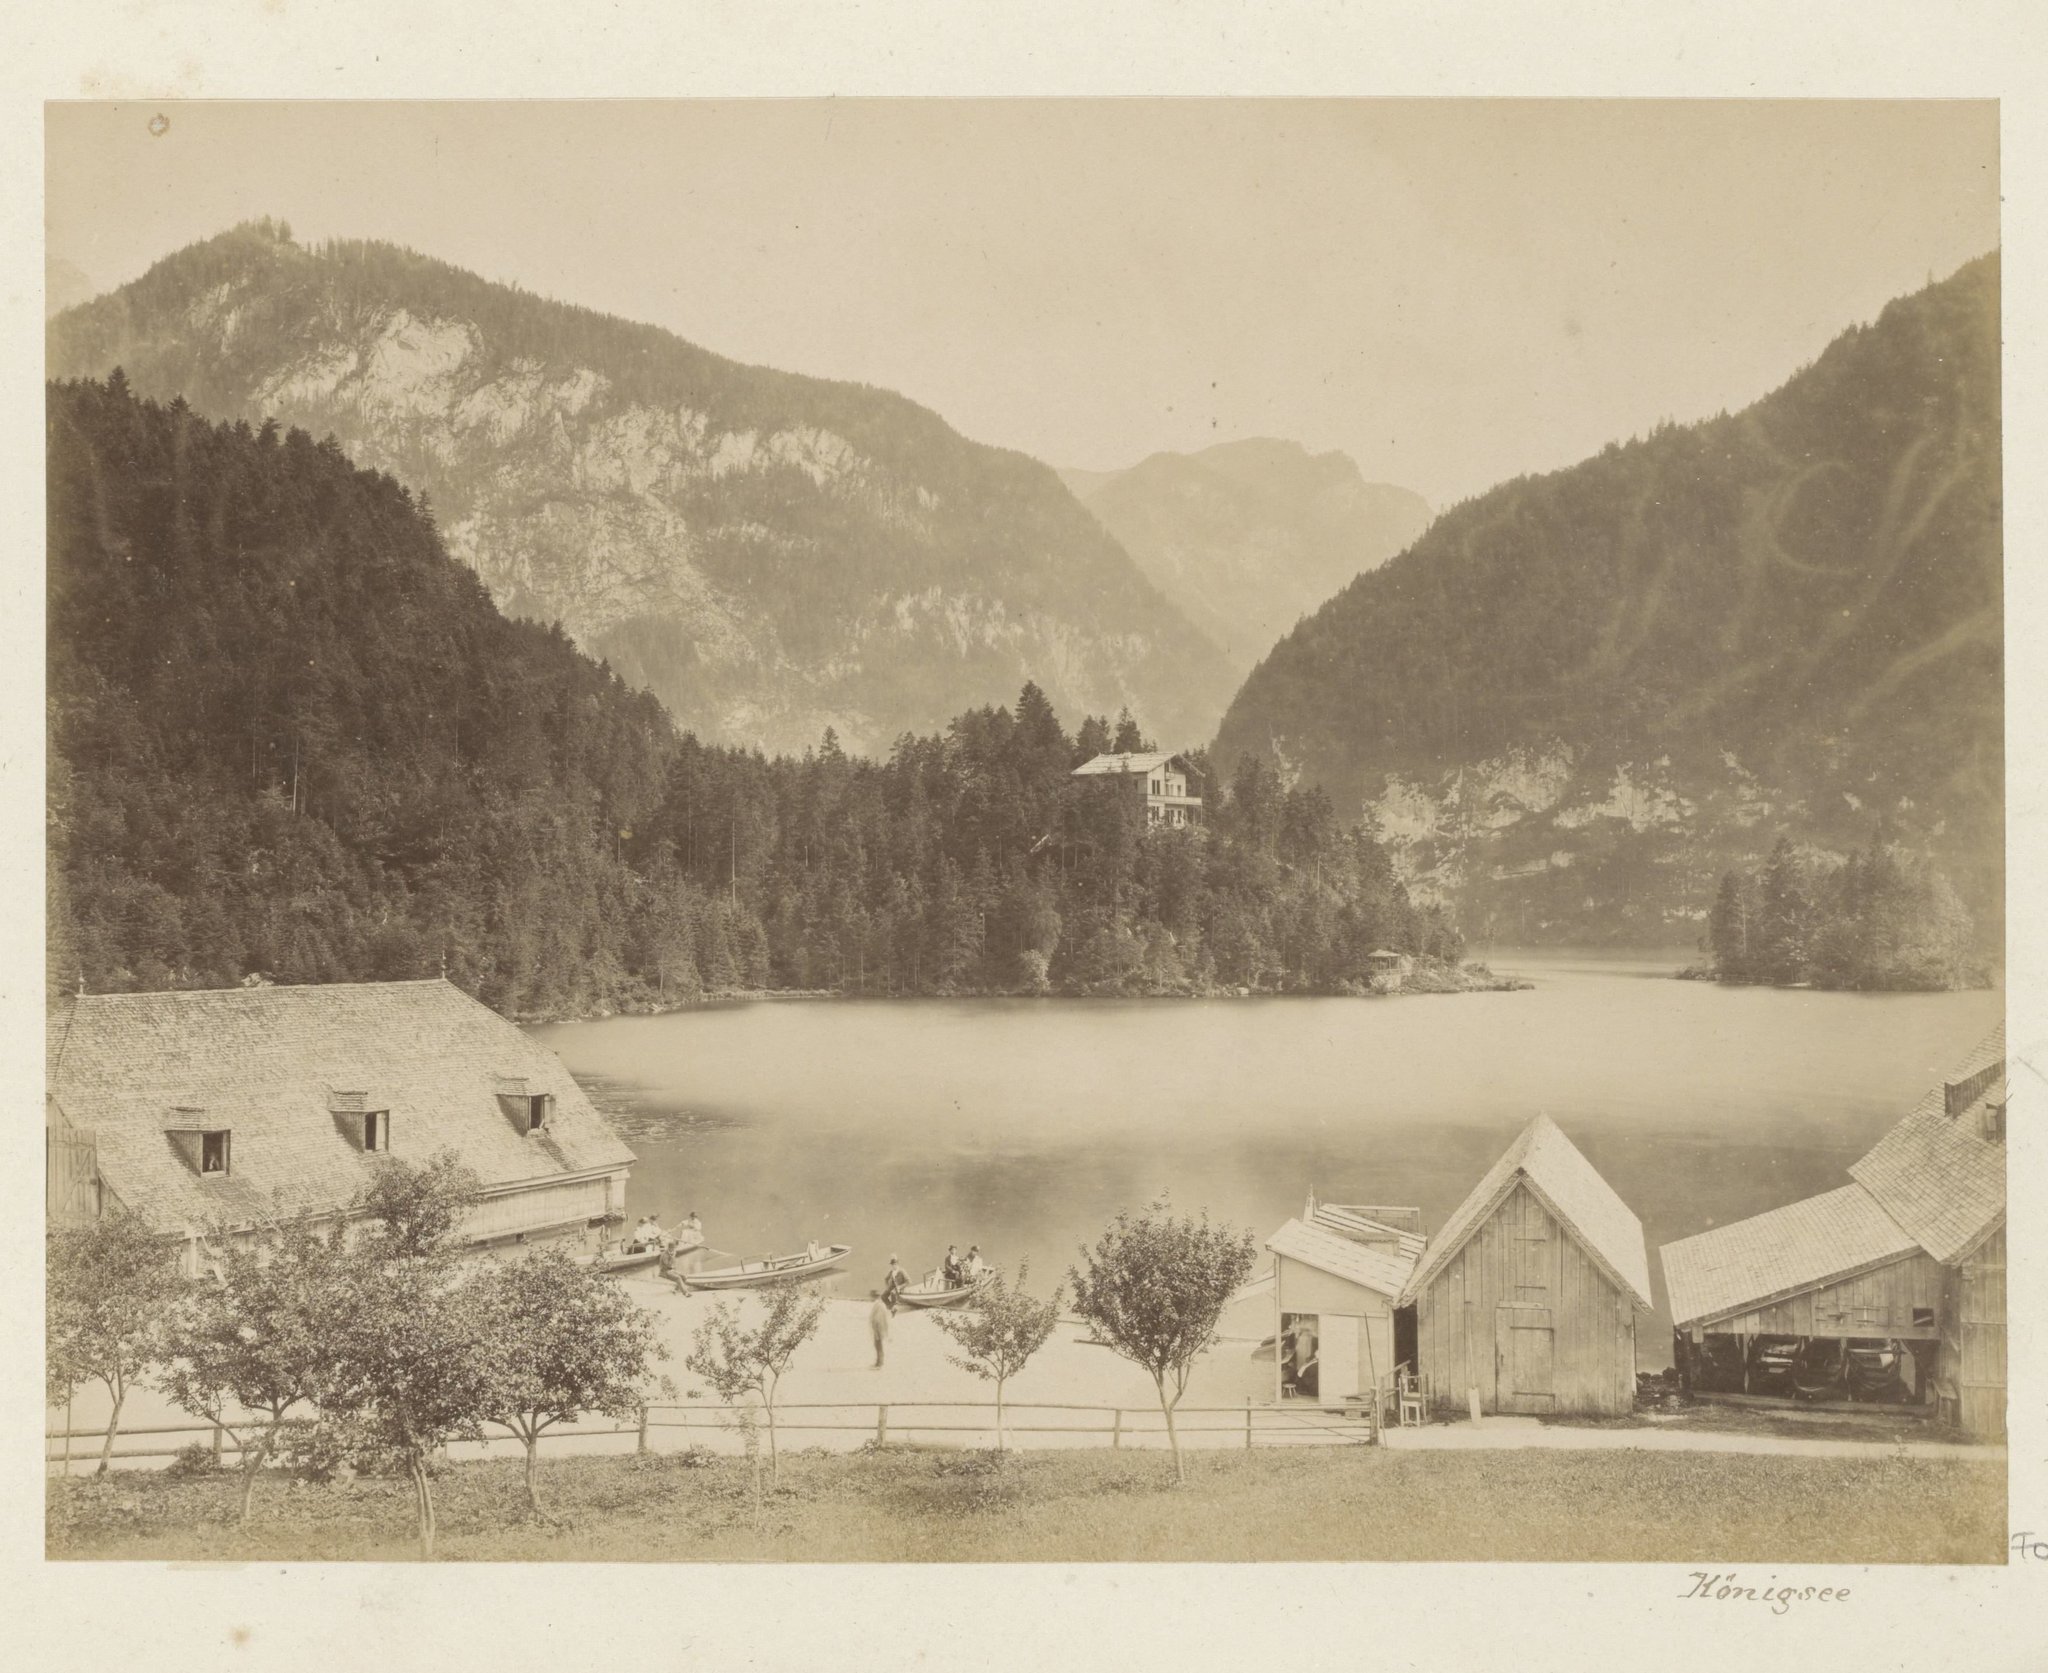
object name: photograph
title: Gezicht op de Königssee in Beieren met op de voorgrond boten en huizen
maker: Anonymous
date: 1860-1890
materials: paper, photographic support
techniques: albumen print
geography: königssee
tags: lake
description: Onderdeel van Reisalbum met foto's van Zwitserland, Oostenrijk, Italië en Duitsland.